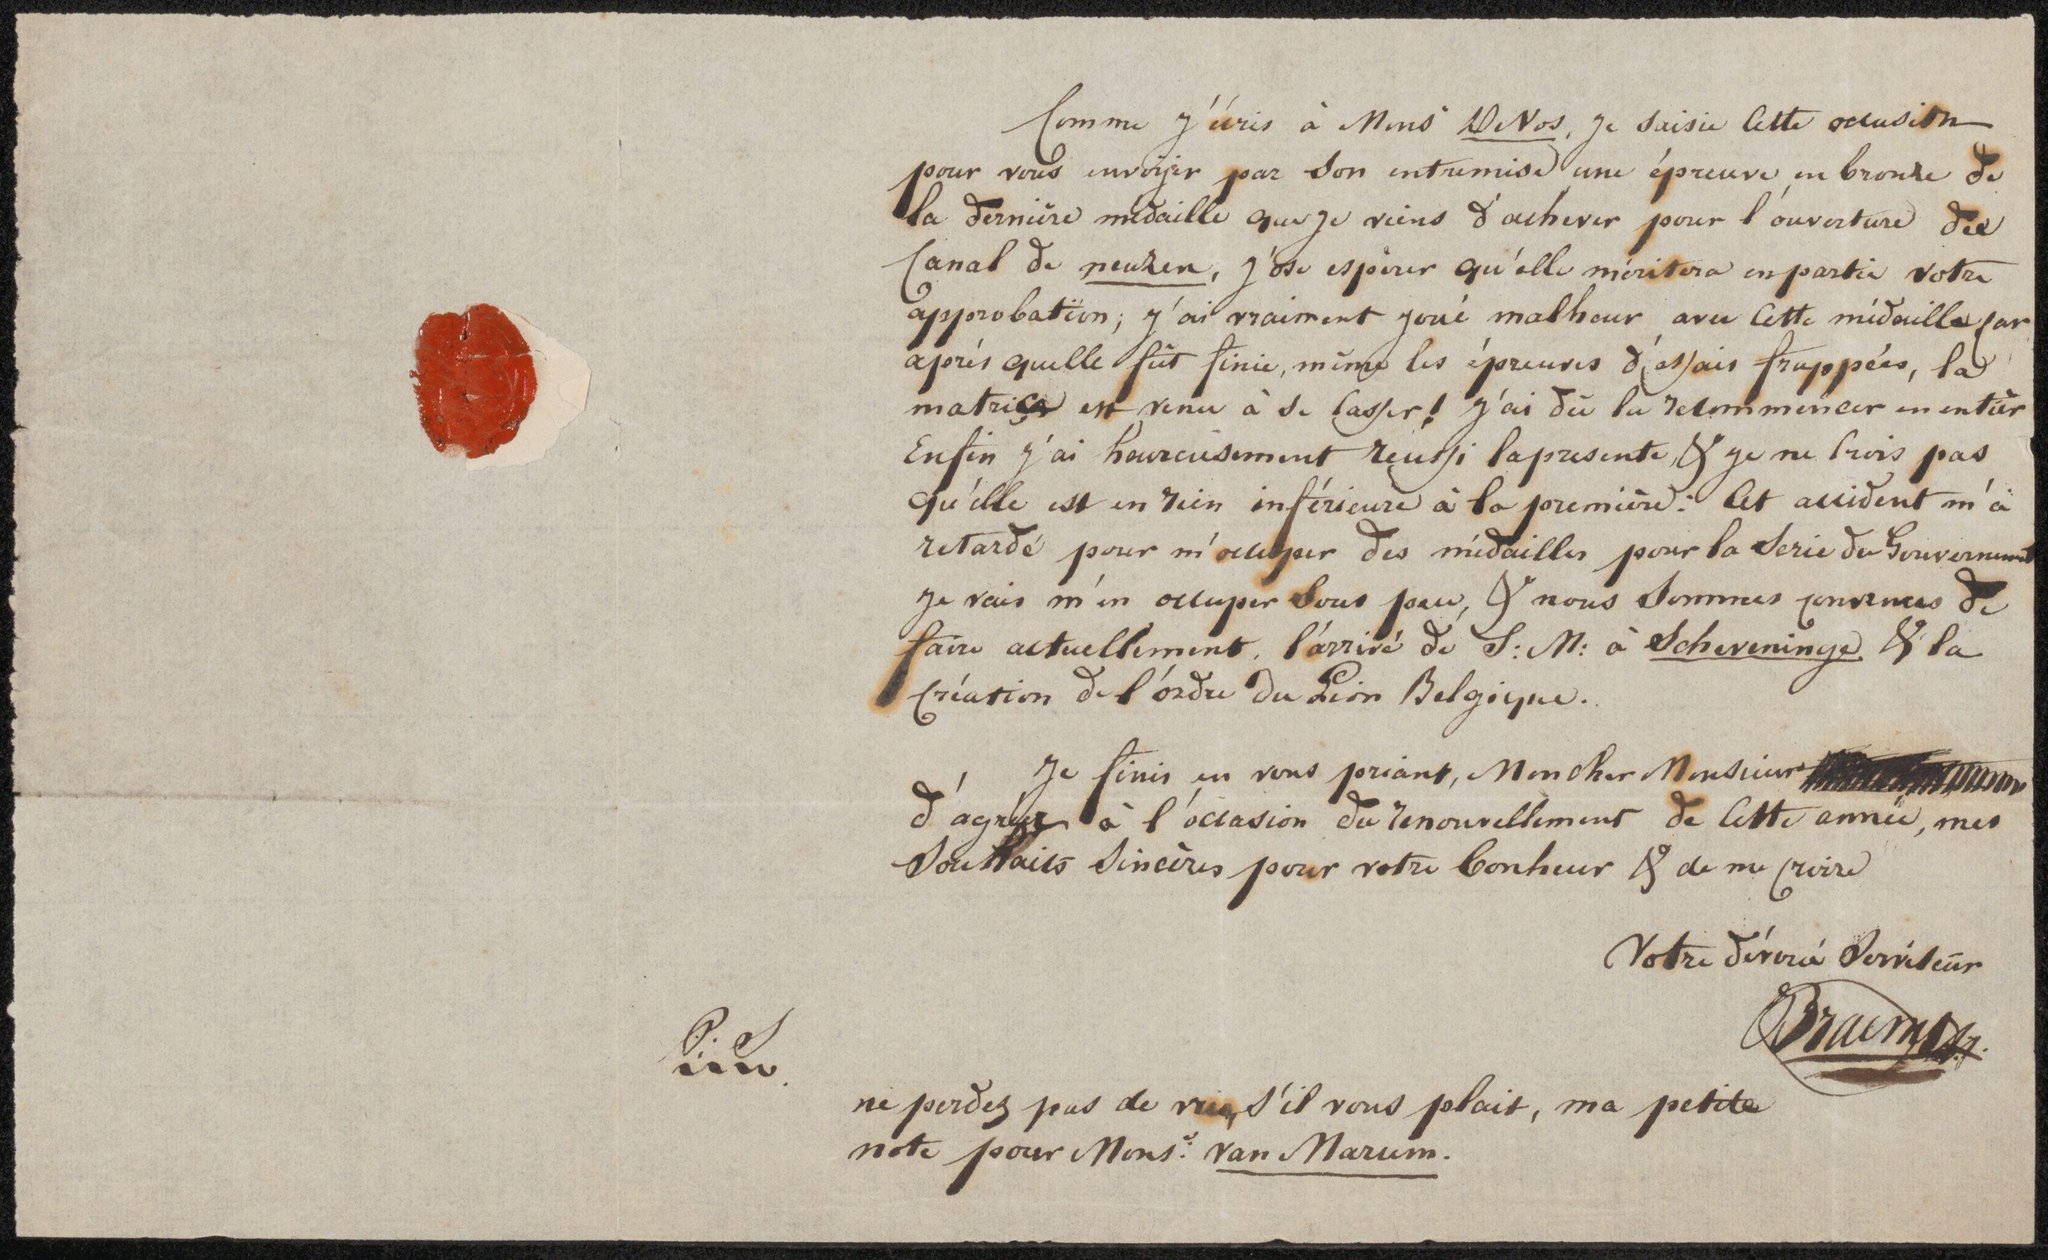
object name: letter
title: Brief aan onbekend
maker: joseph pierre braemt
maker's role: print maker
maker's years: 1796-1864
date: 1806-1864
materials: ink, paper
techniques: pen, writing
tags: delft, physicist, applied arts, arts and crafts; industrial design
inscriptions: seal, collector's mark: Lugt 2233